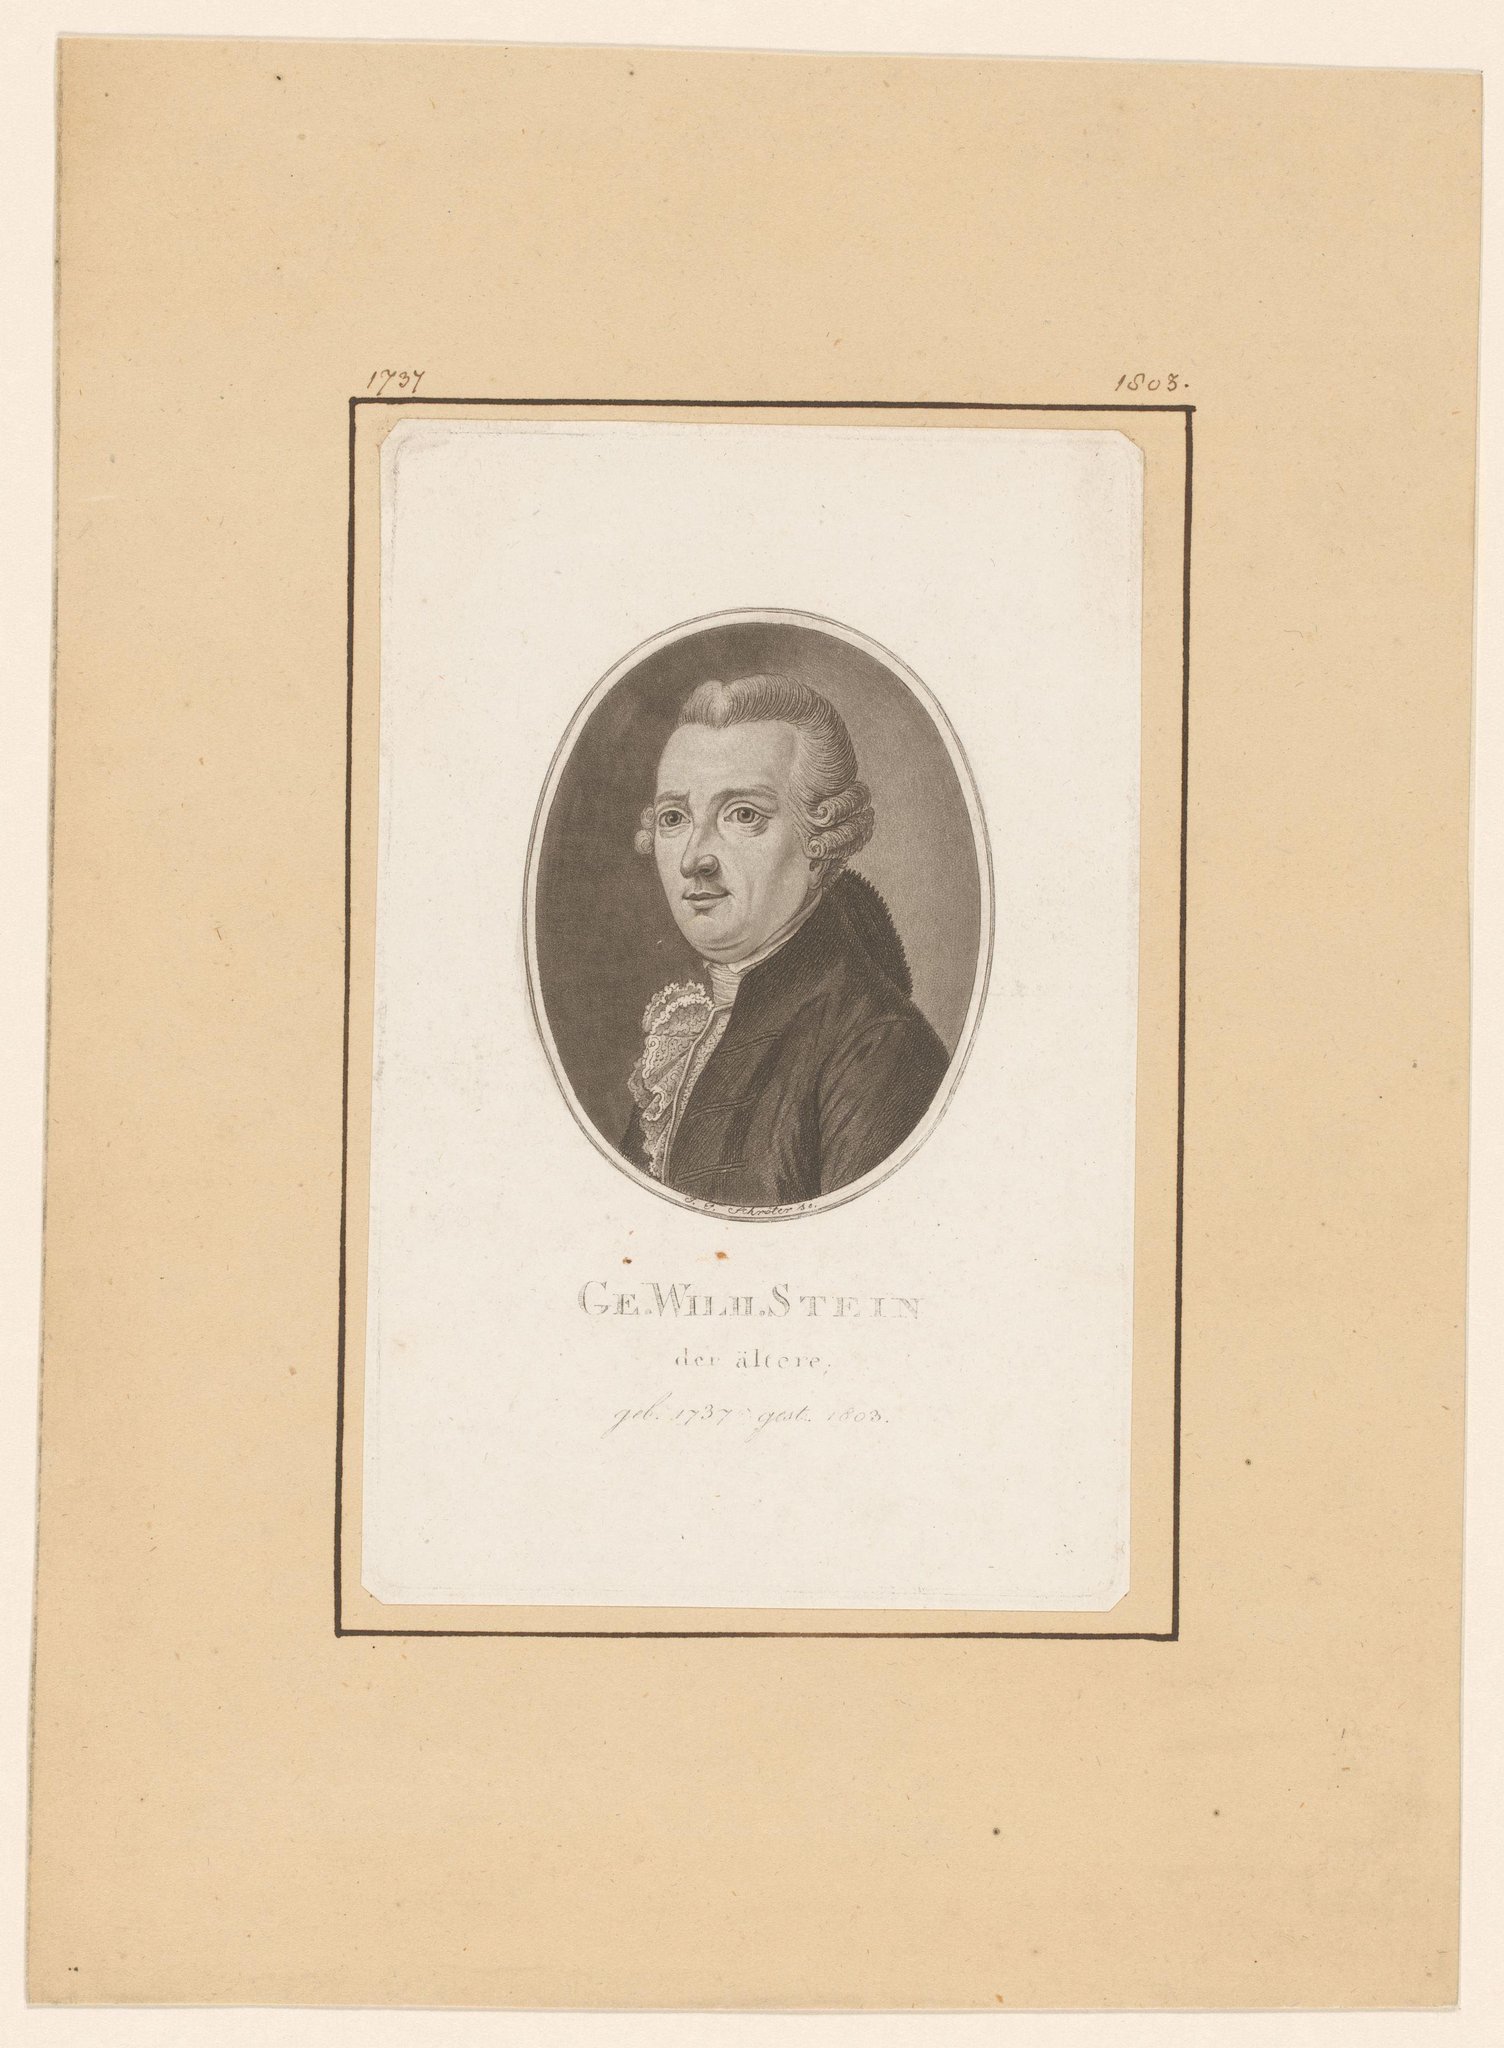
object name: print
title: Portret van Georg Wilhelm Stein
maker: johan friedrich schrötter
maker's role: print maker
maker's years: 1770-1836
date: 1780-1836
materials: paper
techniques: aquatint, etching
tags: historical persons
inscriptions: collector's mark: Lugt 2228